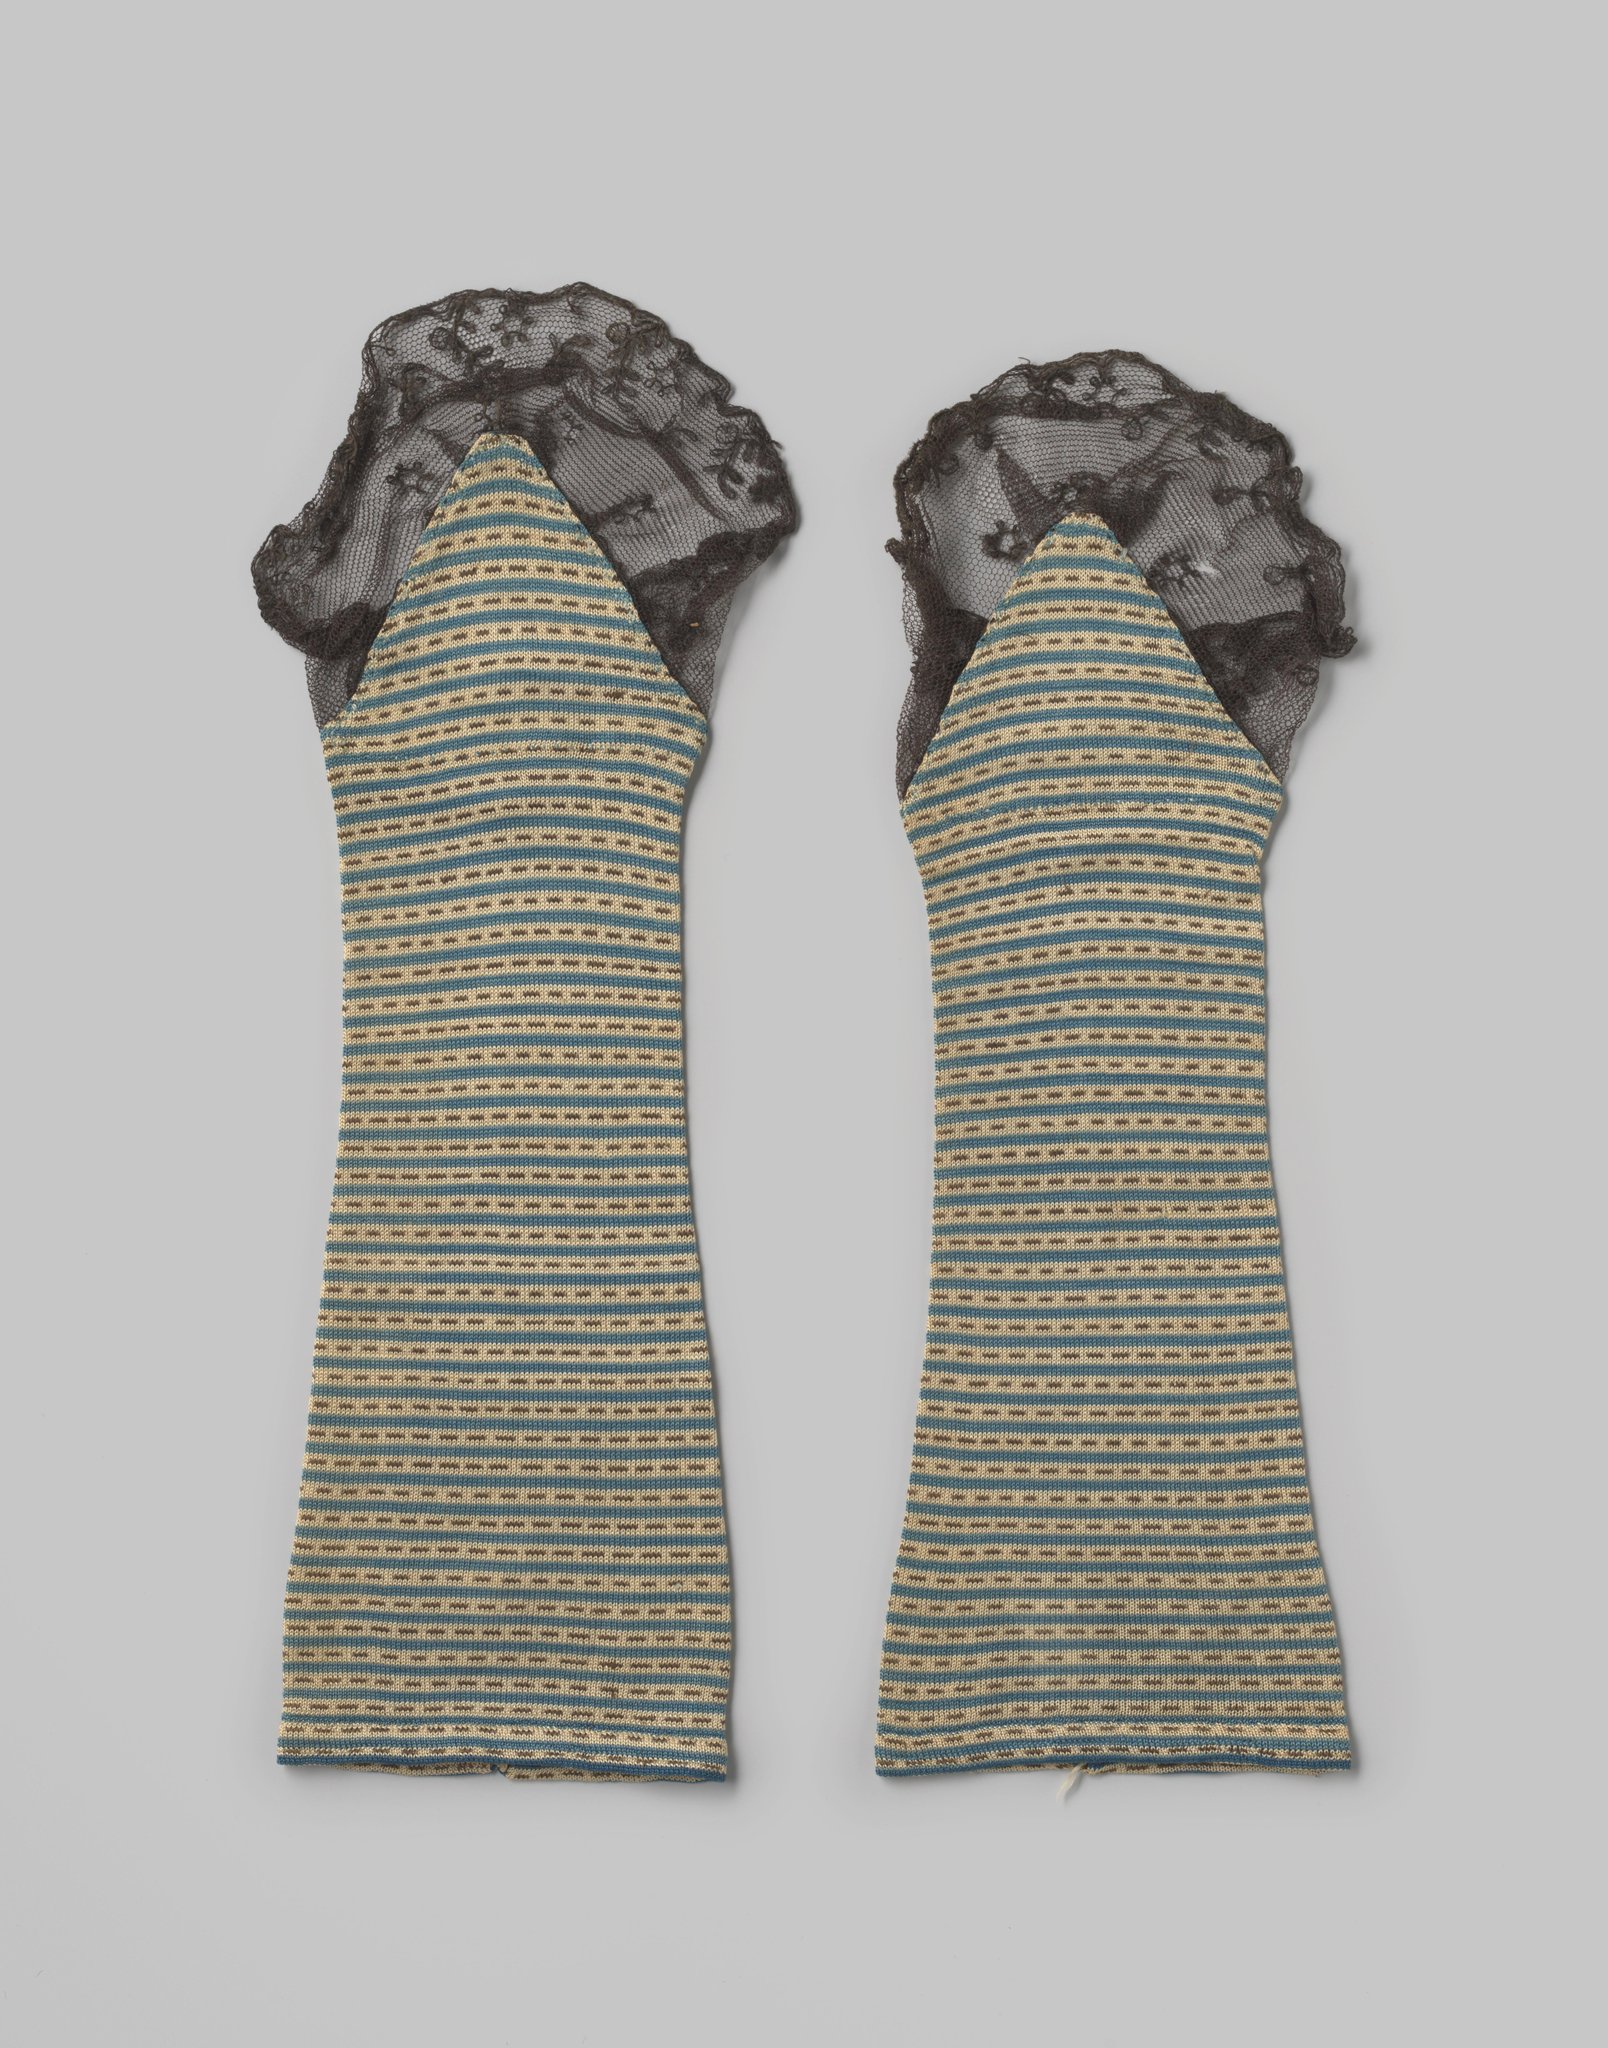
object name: clothing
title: Mitaine van bauw wit gestreepte zijde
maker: Anonymous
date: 1750-1800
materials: silk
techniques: knitting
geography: zaanstreek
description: Een paar zijden mitaines in de breedte afwisselend blauw- en witgestreept. De witte banen zijn met zwartzijden langwerpige vierkanten versierd. De onderzijde is van zwarte zijde voorzien.